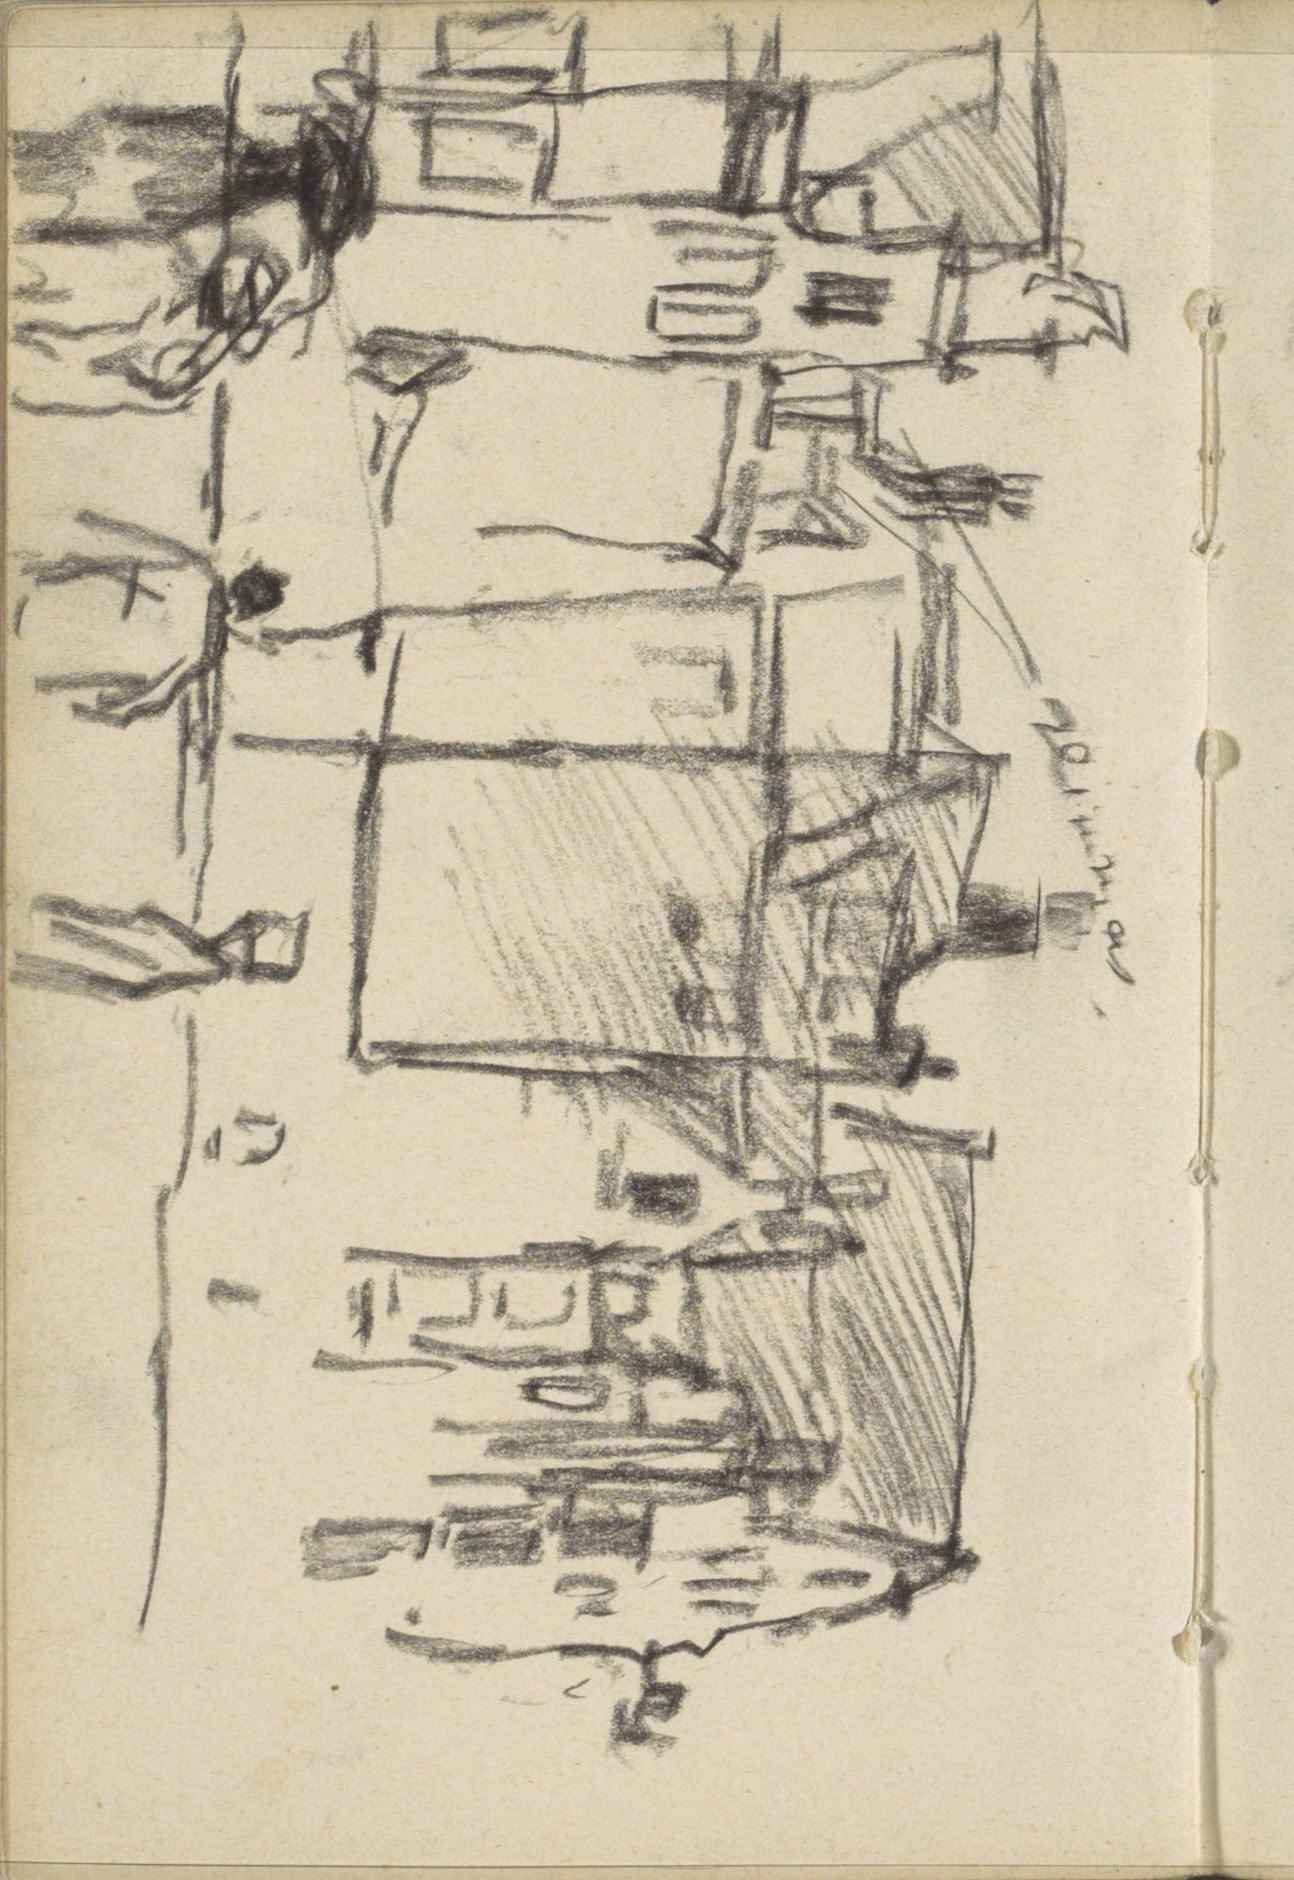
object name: sketchbook leaf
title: Gezicht in Amsterdam, mogelijk het Rokin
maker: george hendrik breitner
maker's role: draughtsman, painter, print maker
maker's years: 1857-1923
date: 1909-1912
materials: chalk, paper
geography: amsterdam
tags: urban housing, canals, waters (in city)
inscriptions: kleurnotitie, handgeschreven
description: Gezicht in Amsterdam, mogelijk het Rokin. Vooraan figuren. Pagina 83 uit een schetsboek met 46 bladen vervaardigd te Amsterdam.